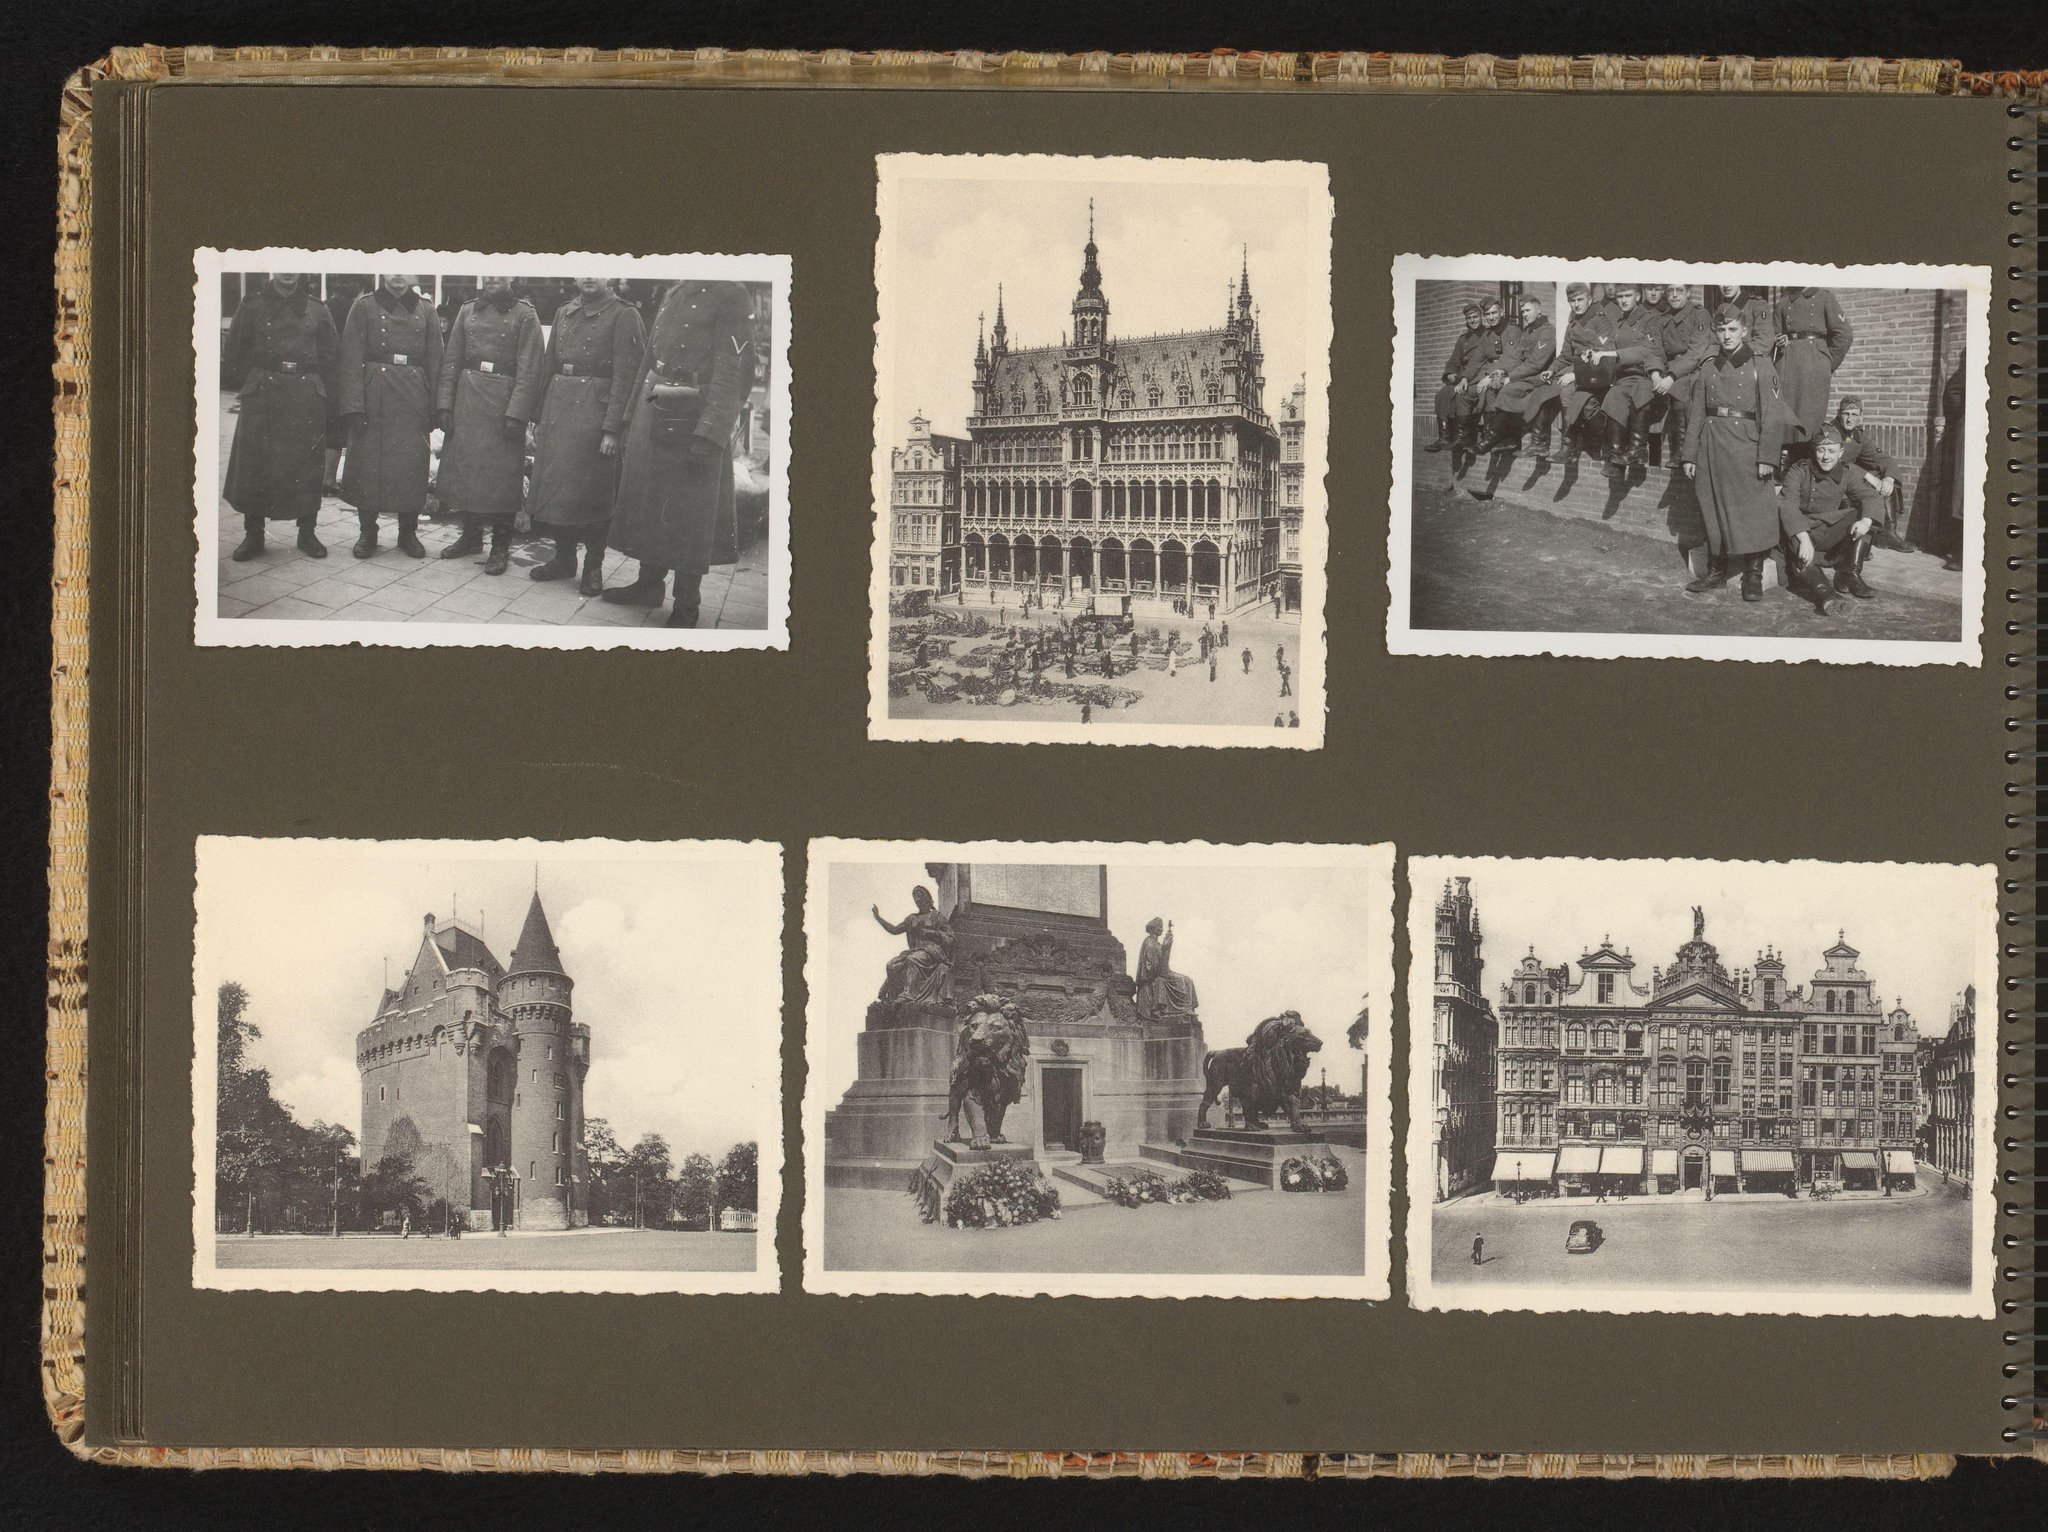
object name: photomechanical print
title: Soldaten en Brussel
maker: Anonymous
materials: cardboard, photographic support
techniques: photograph, gelatin silver print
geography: netherlands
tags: square, place, circus, etc., the company, the unit, the troop ~ military service, netherlands, brussels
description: Albumblad met twee foto's van een groep Duitse soldaten in Nederland en vier gekochte lichtdrukken van gebouwen te Brussel. Onderdeel van het fotoalbum Duitse bezetting van Nederland.